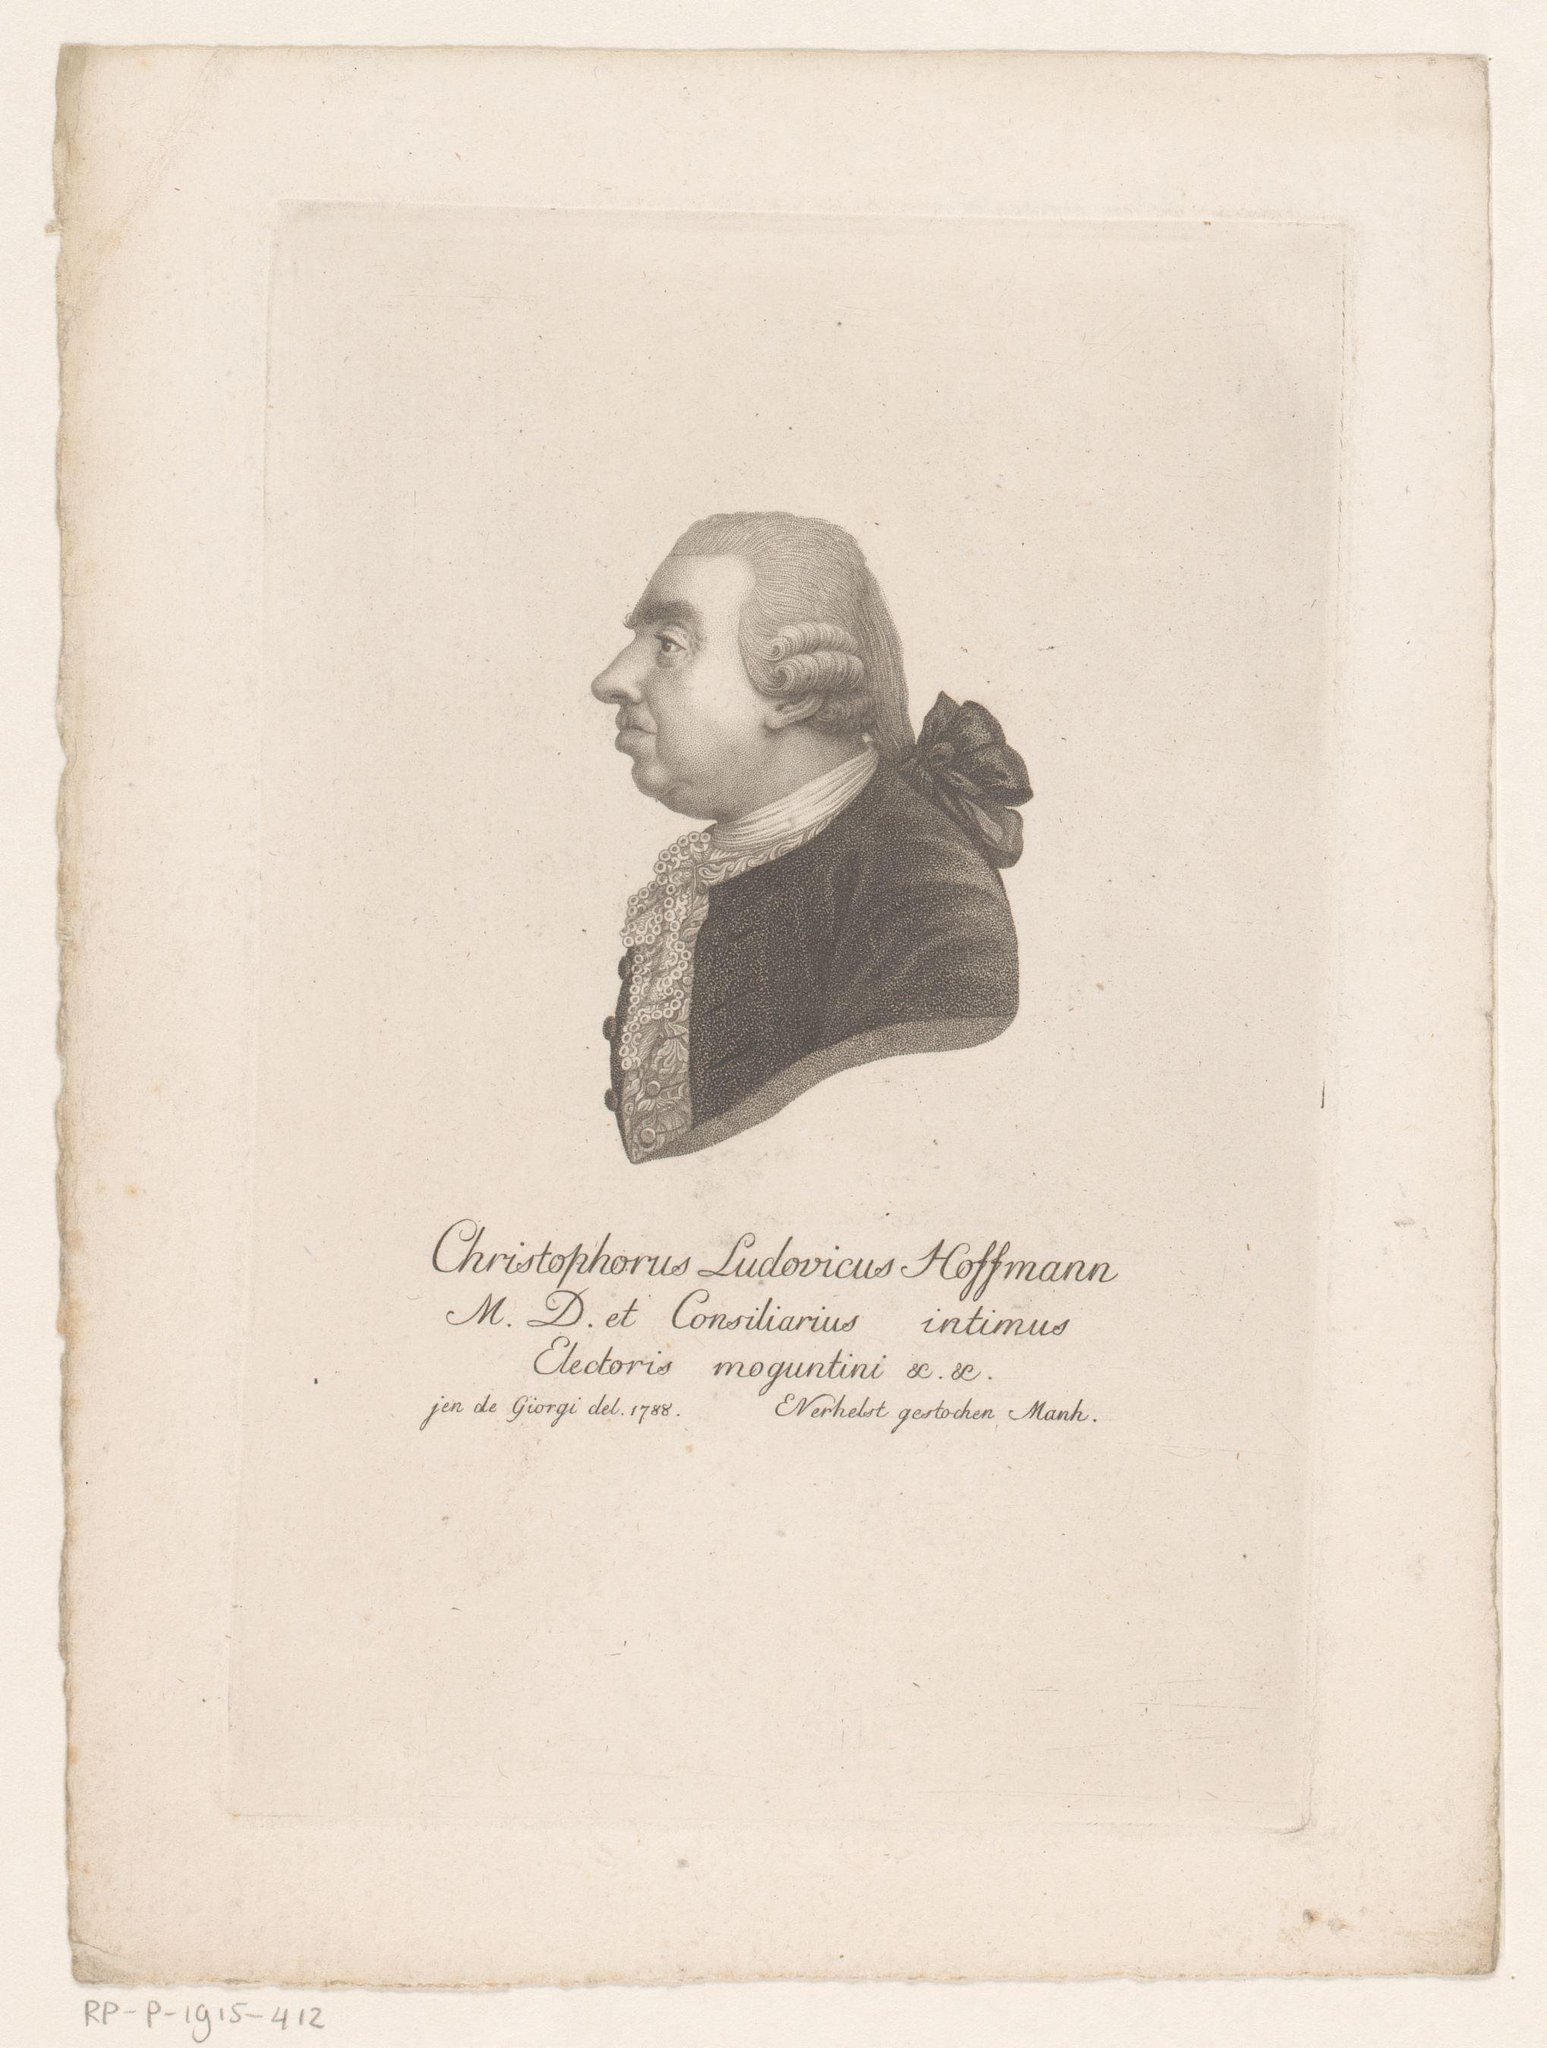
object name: print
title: Portret van Christoph Ludwig von Hoffmann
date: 1788-1818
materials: paper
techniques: engraving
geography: mannheim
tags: westphalia, historical persons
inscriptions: collector's mark: Lugt 2228